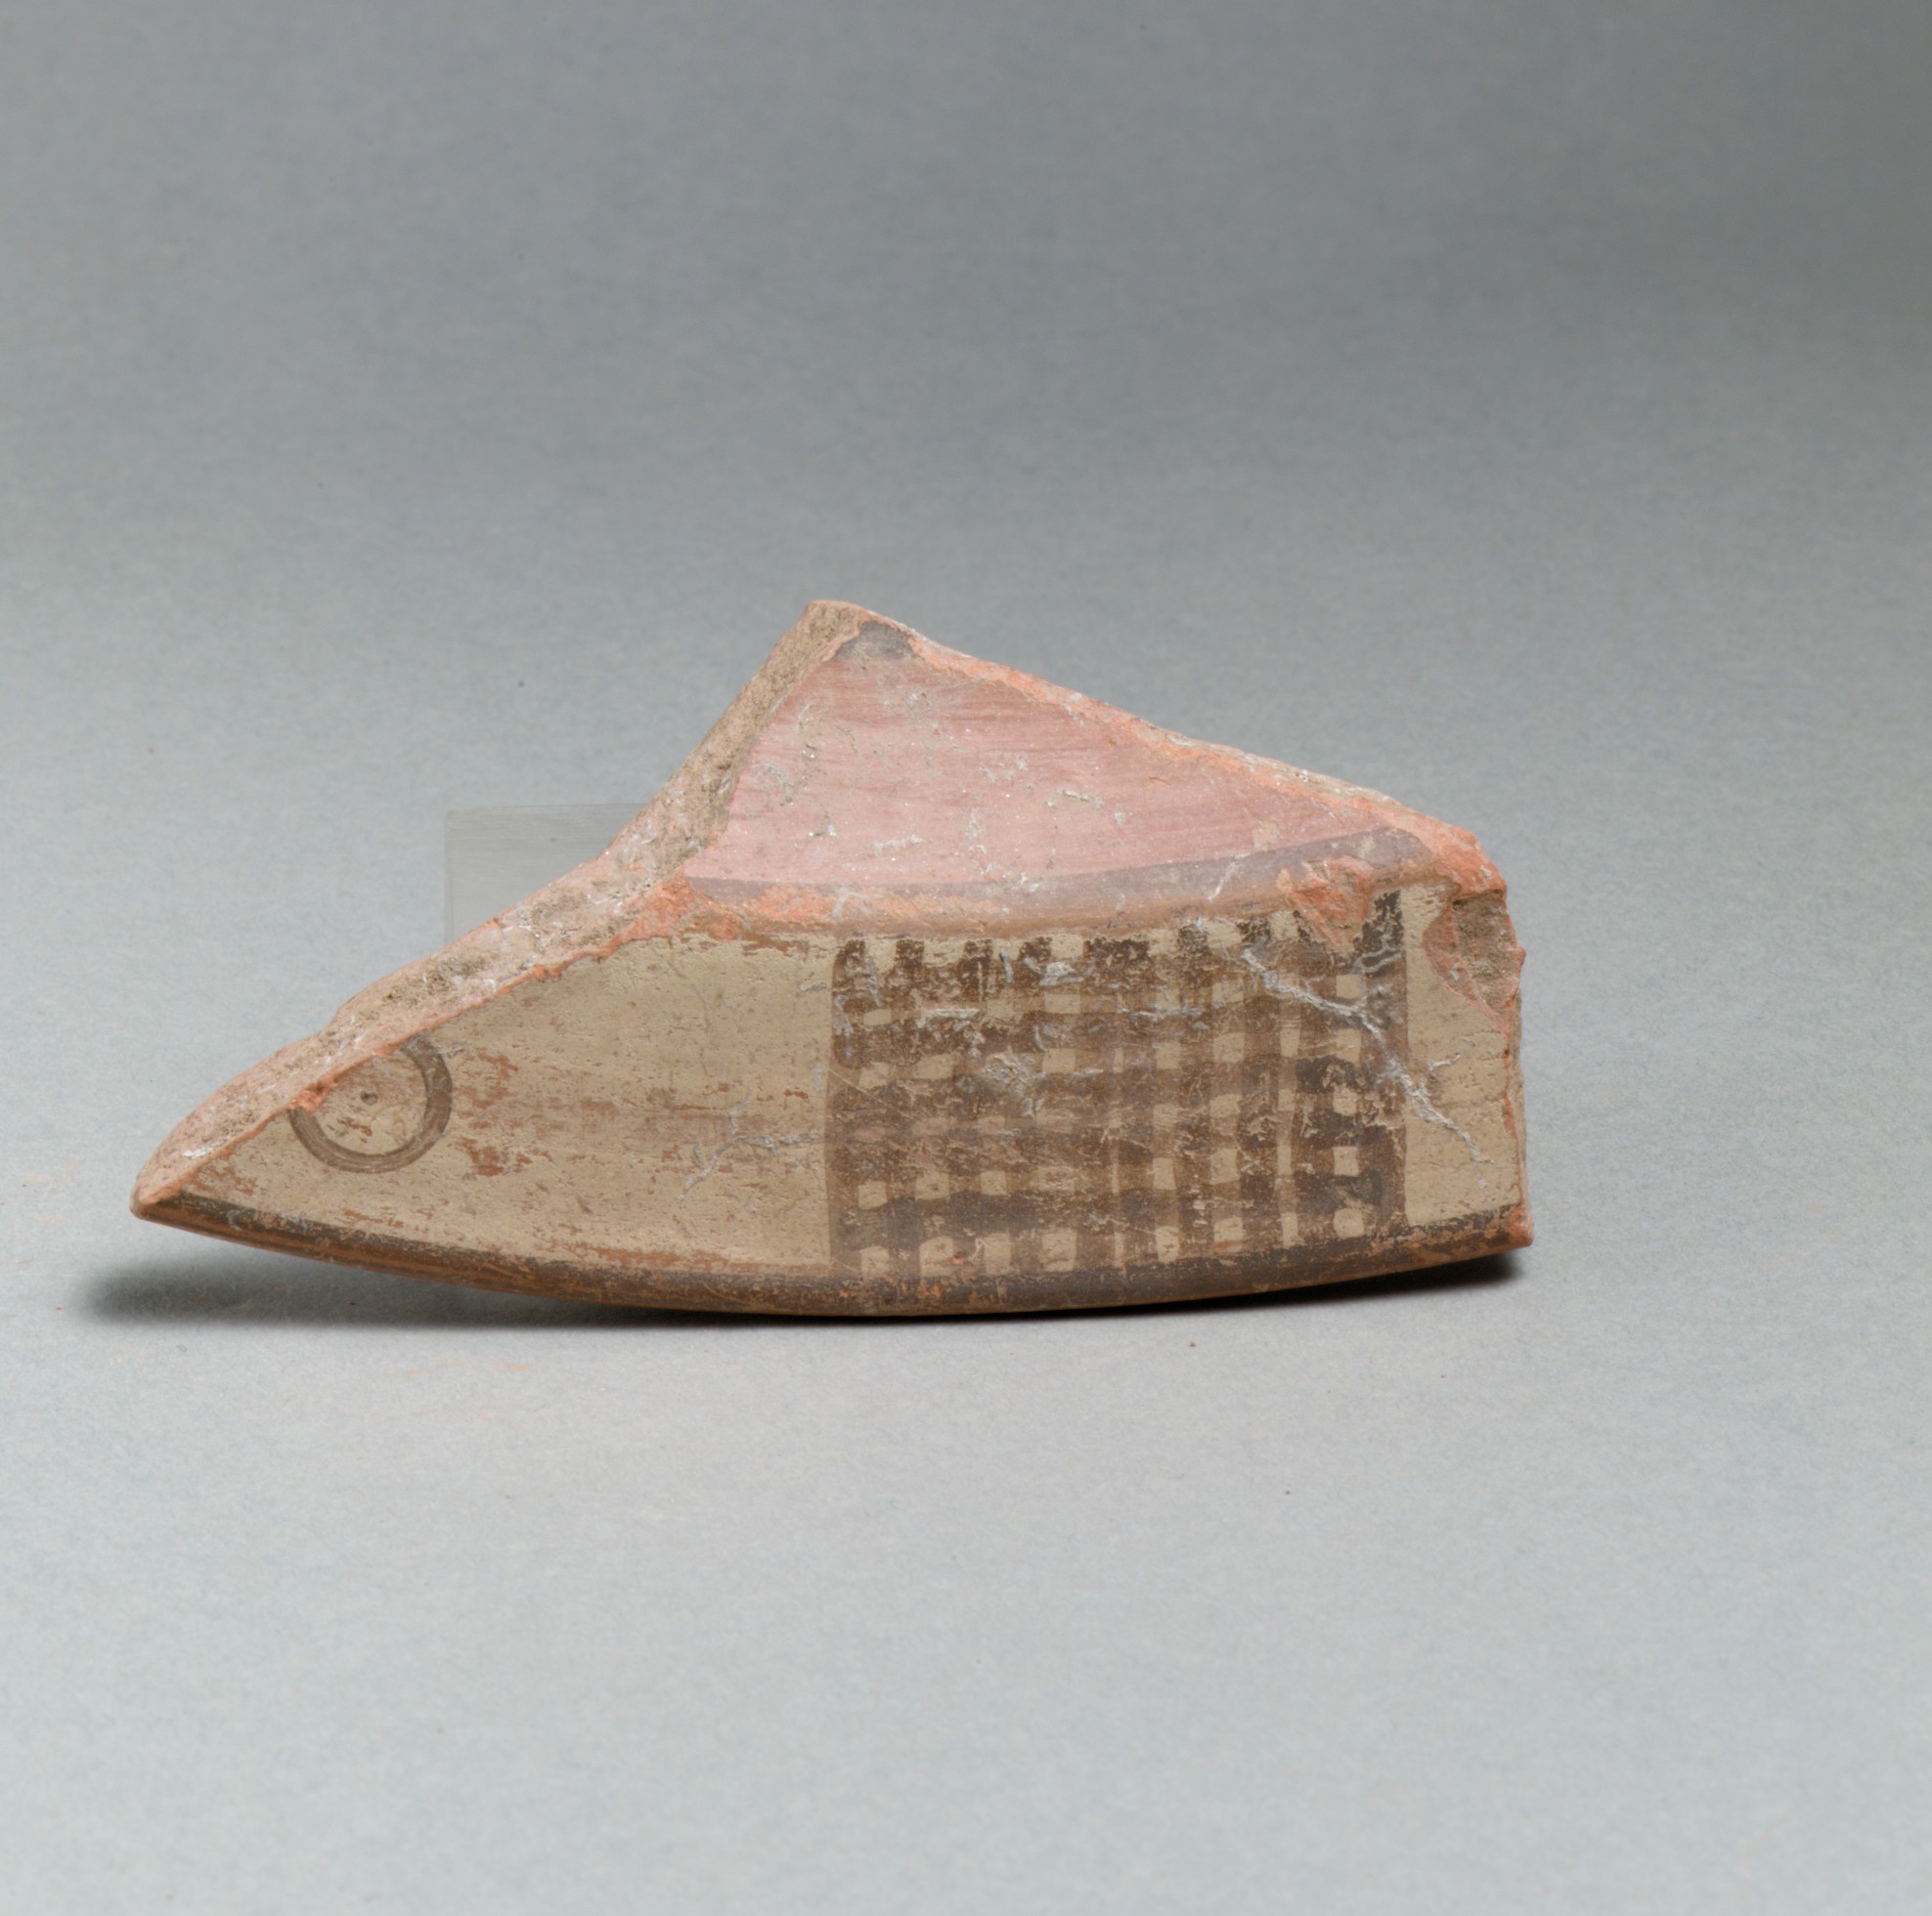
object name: vase fragment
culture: greek or lydian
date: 1050-700 BCE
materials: terracotta